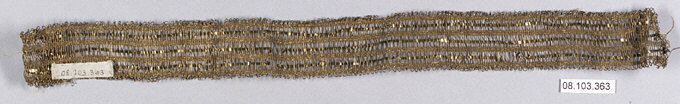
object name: galloon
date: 1601-1800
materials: metal thread